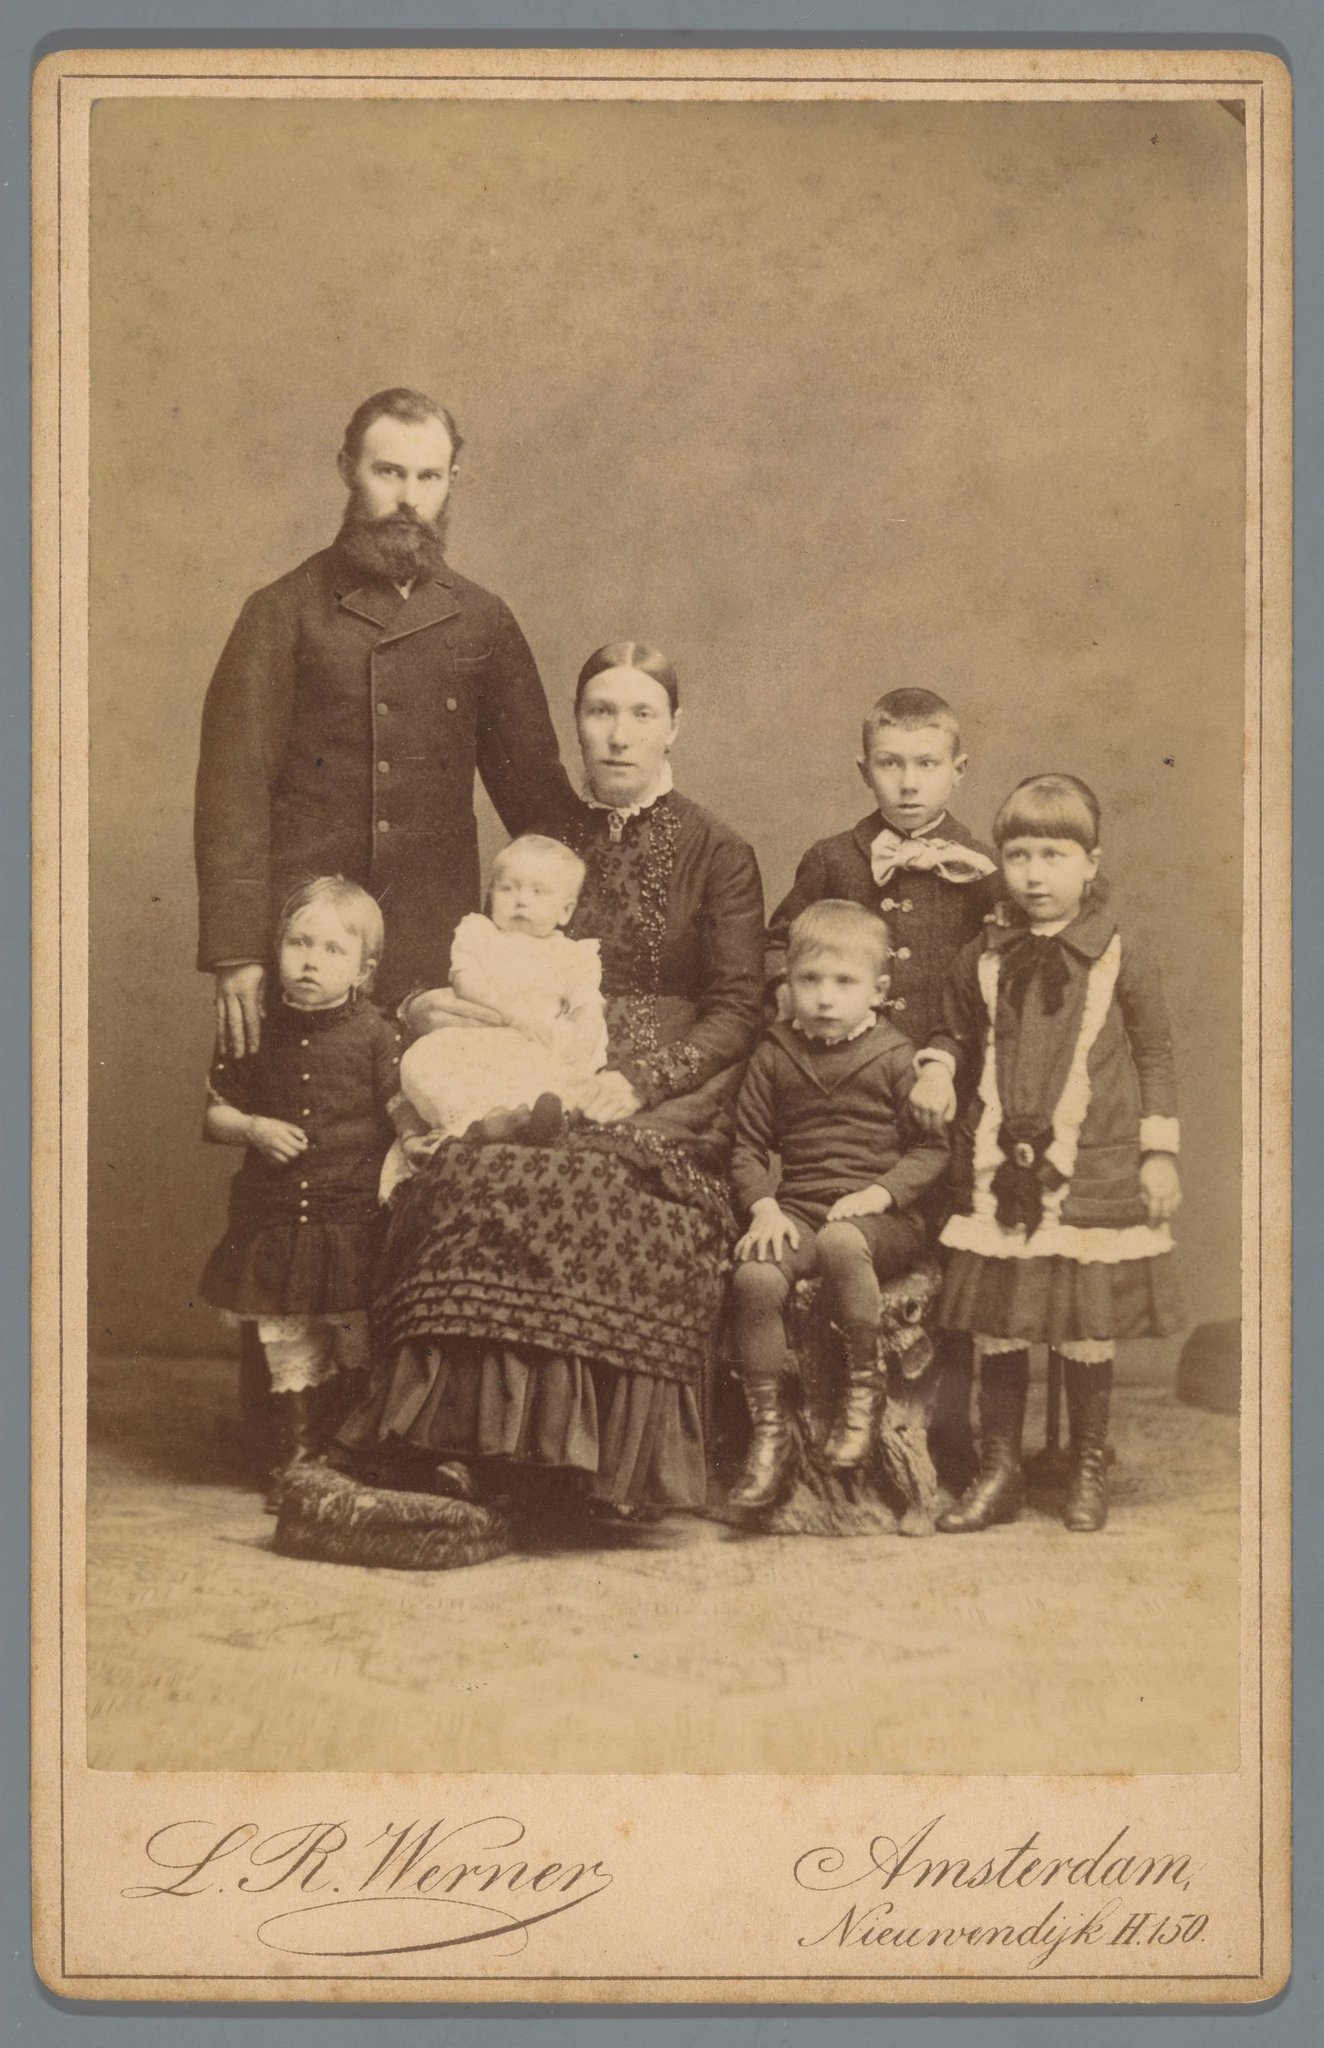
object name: cabinet photograph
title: Portret van een onbekend gezin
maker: louis robert werner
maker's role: fotograaf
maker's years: 1834-1896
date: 1880-1900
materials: cardboard, photographic support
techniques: albumen print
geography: amsterdam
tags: family group, especially parents with their child(ren)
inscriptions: inscription: ‘L.R. Werner (...) kunnen iederen tijd geleverd worden.’